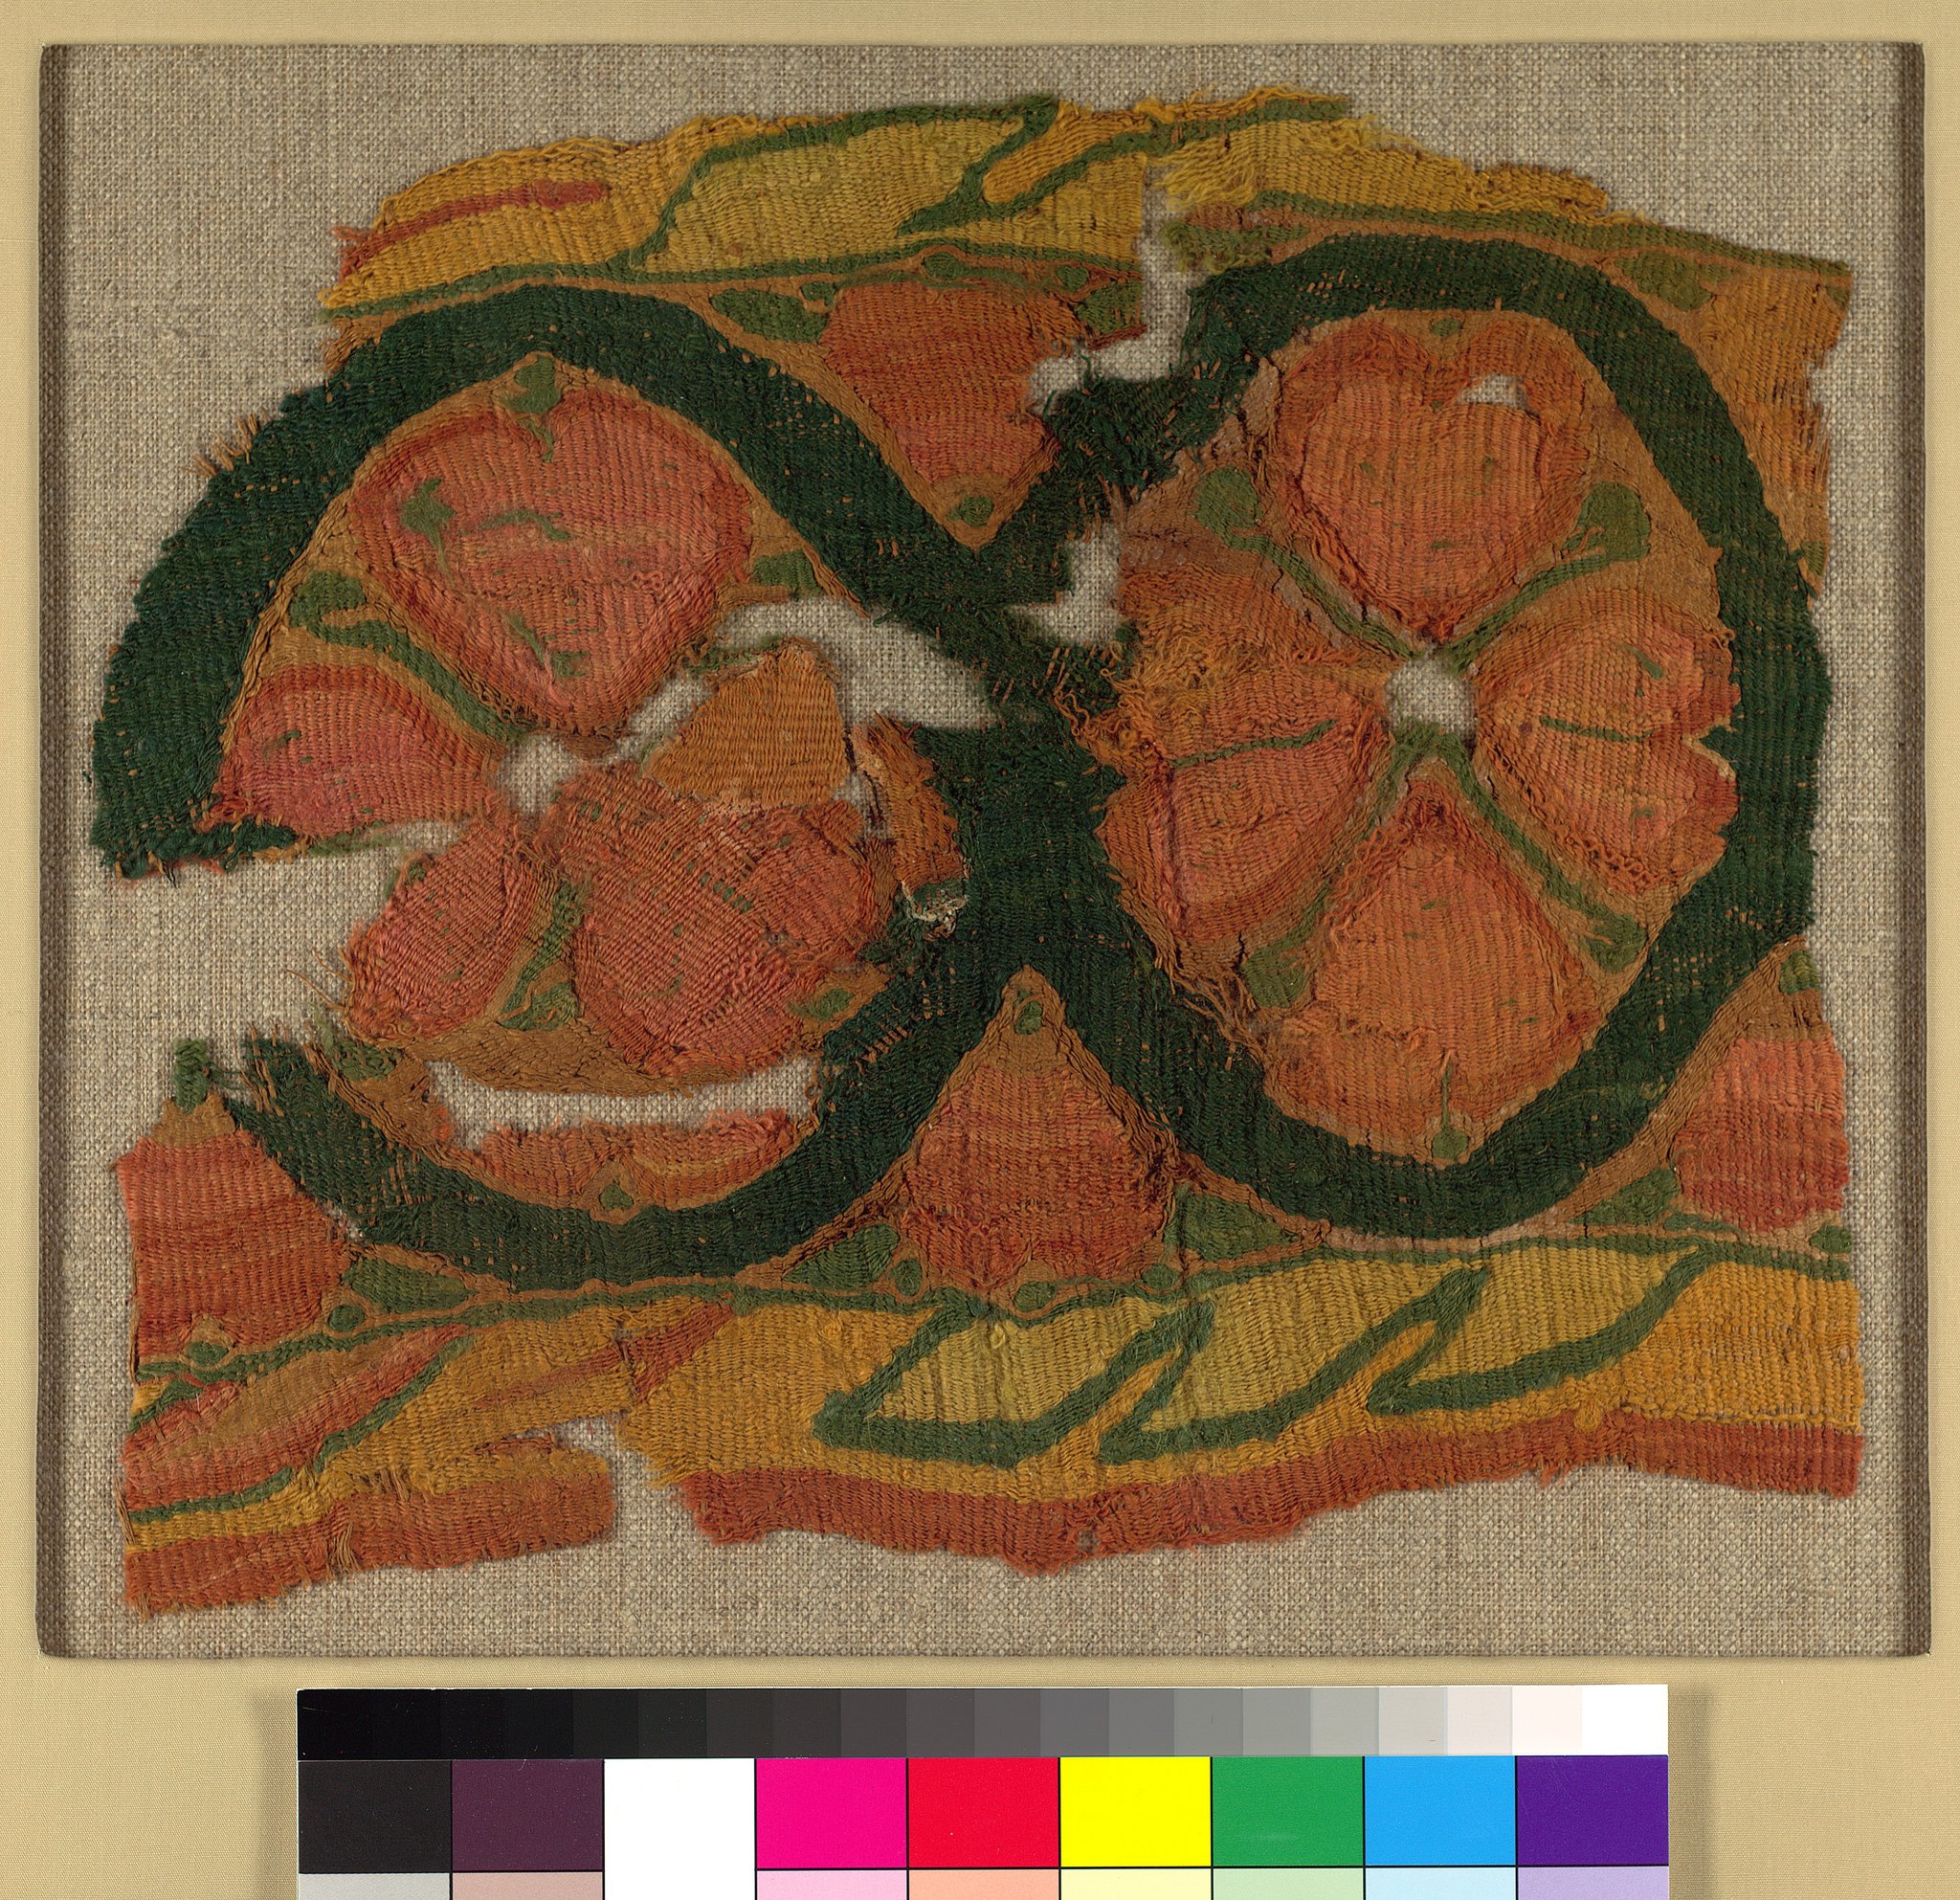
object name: textile fragment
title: Fragment of a Band with a Floral Motif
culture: byzantine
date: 401-600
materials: linen, wool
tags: flowers